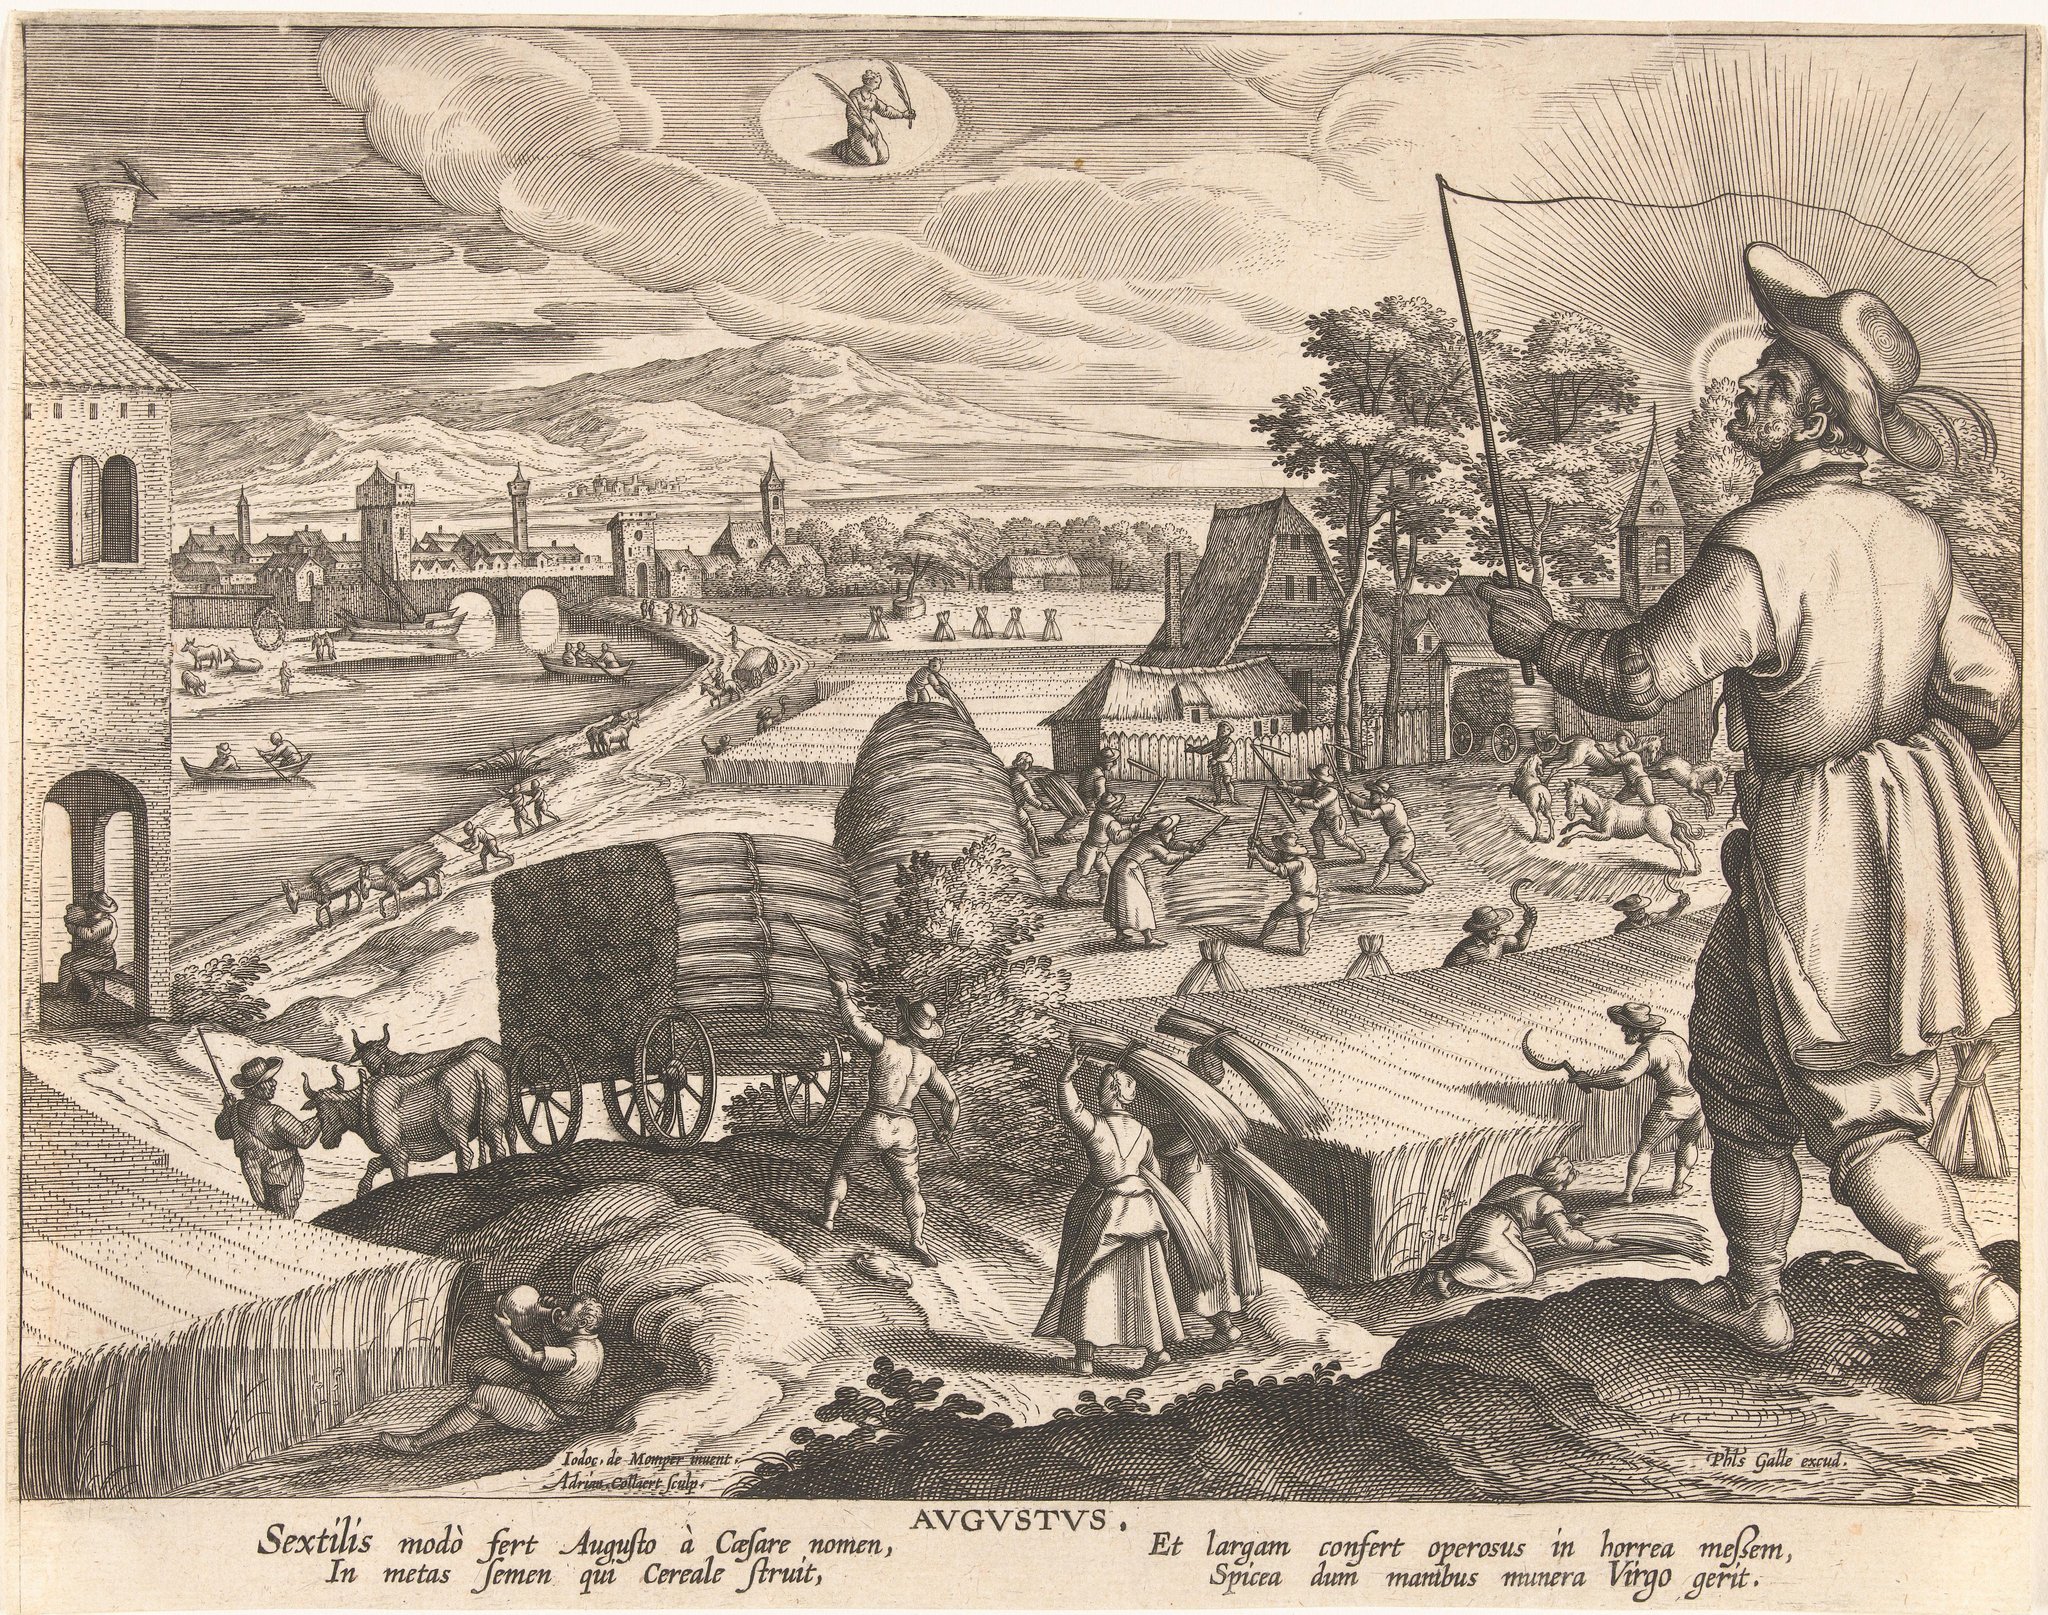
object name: print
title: Avgvstvs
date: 1586-1618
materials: paper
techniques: engraving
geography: antwerp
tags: harvest, august and its 'labours' (+ with zodiacal signs), whip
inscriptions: collector's mark: Lugt 2228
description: Op de voorgrond rechts staat een man van middelbare leeftijd met een zweep in de hand. Op de achtergrond wordt graan geoogst en naar de graanschuur gebracht . Middenboven in de wolken het astrologisch teken van de Maagd. De prent heeft een Latijns onderschrift en is deel van een twaalfdelige serie over de maanden van het jaar.